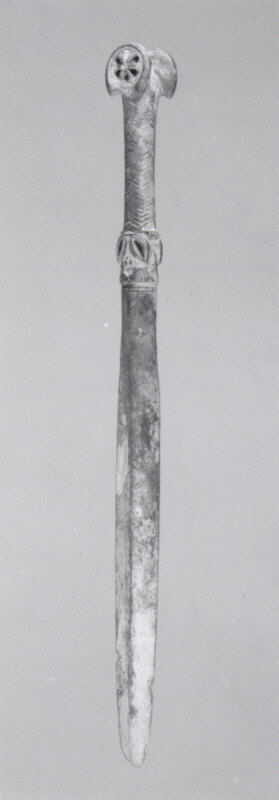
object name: dagger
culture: iranian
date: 1000-1 BCE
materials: bronze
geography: iran